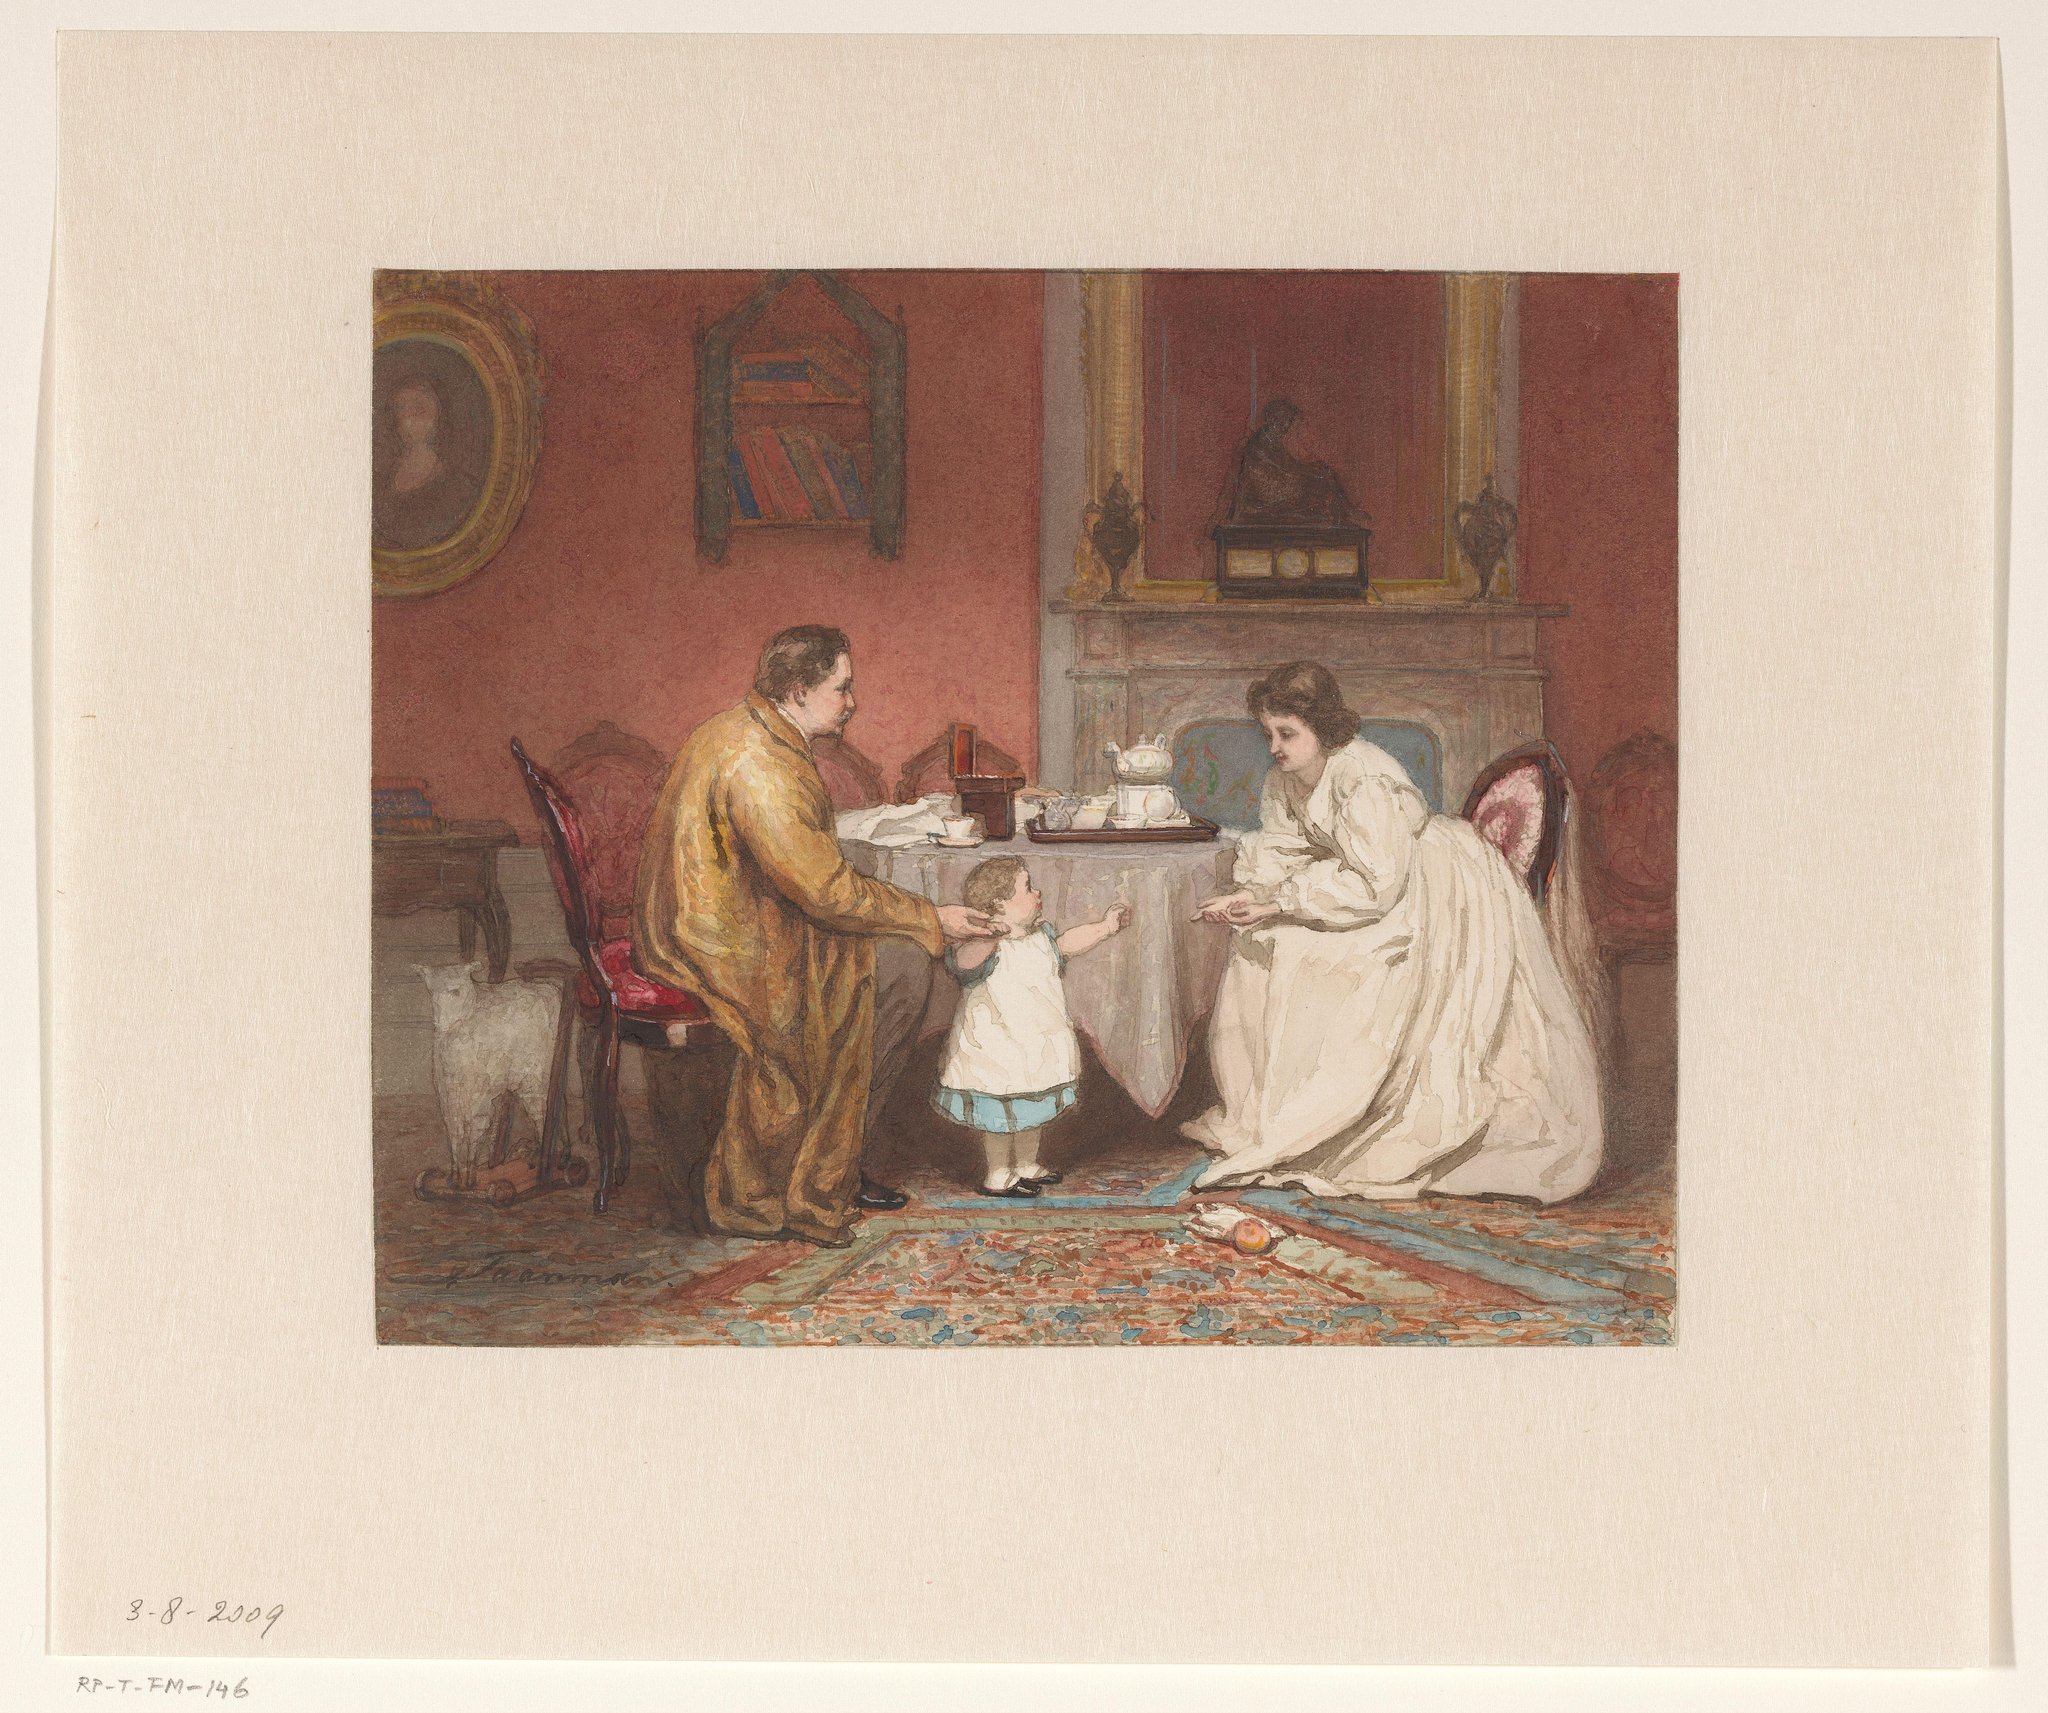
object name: watercolor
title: Interieur met ouders en hun kind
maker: jacob taanman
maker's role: draughtsman, print maker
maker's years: 1836-1923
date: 1846-1923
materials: paper, pencil, watercolor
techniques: brush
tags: interior of the house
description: Interieur met ouders en hun kind, links een schaap op wieltjes.